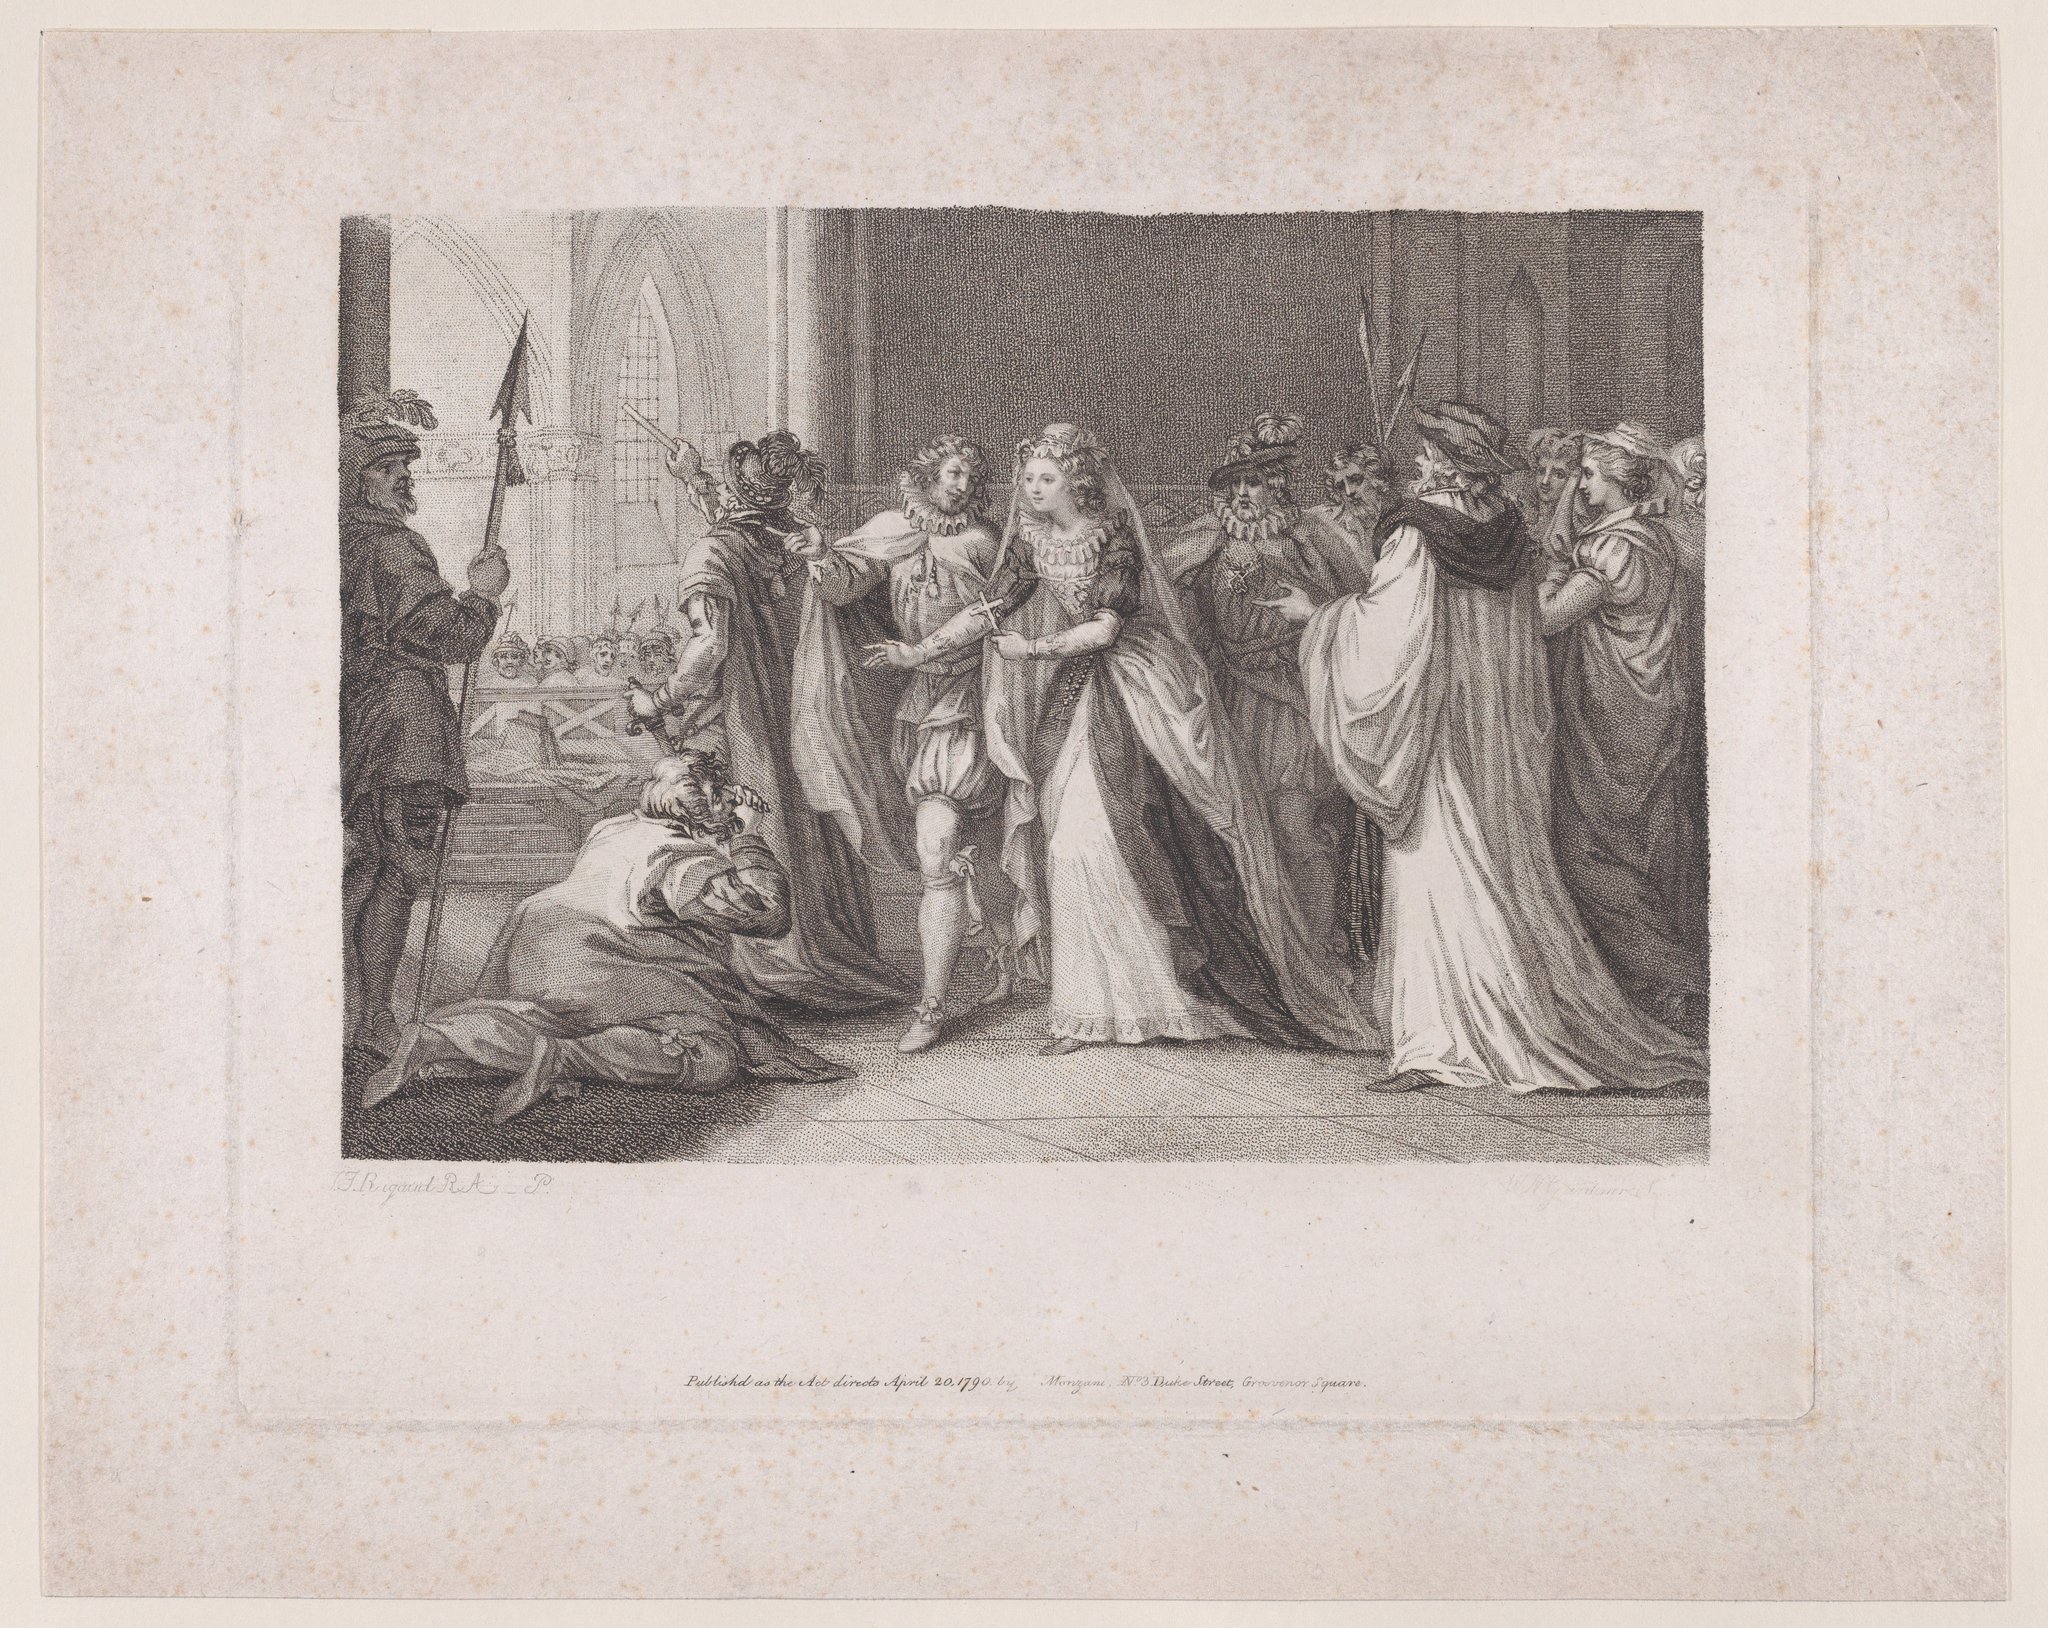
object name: print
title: Mary, Queen of Scots going to the place of execution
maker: william nelson gardiner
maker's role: artist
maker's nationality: british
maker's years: 1766-1814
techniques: engraving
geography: england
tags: queens,men,women,mary queen of scots